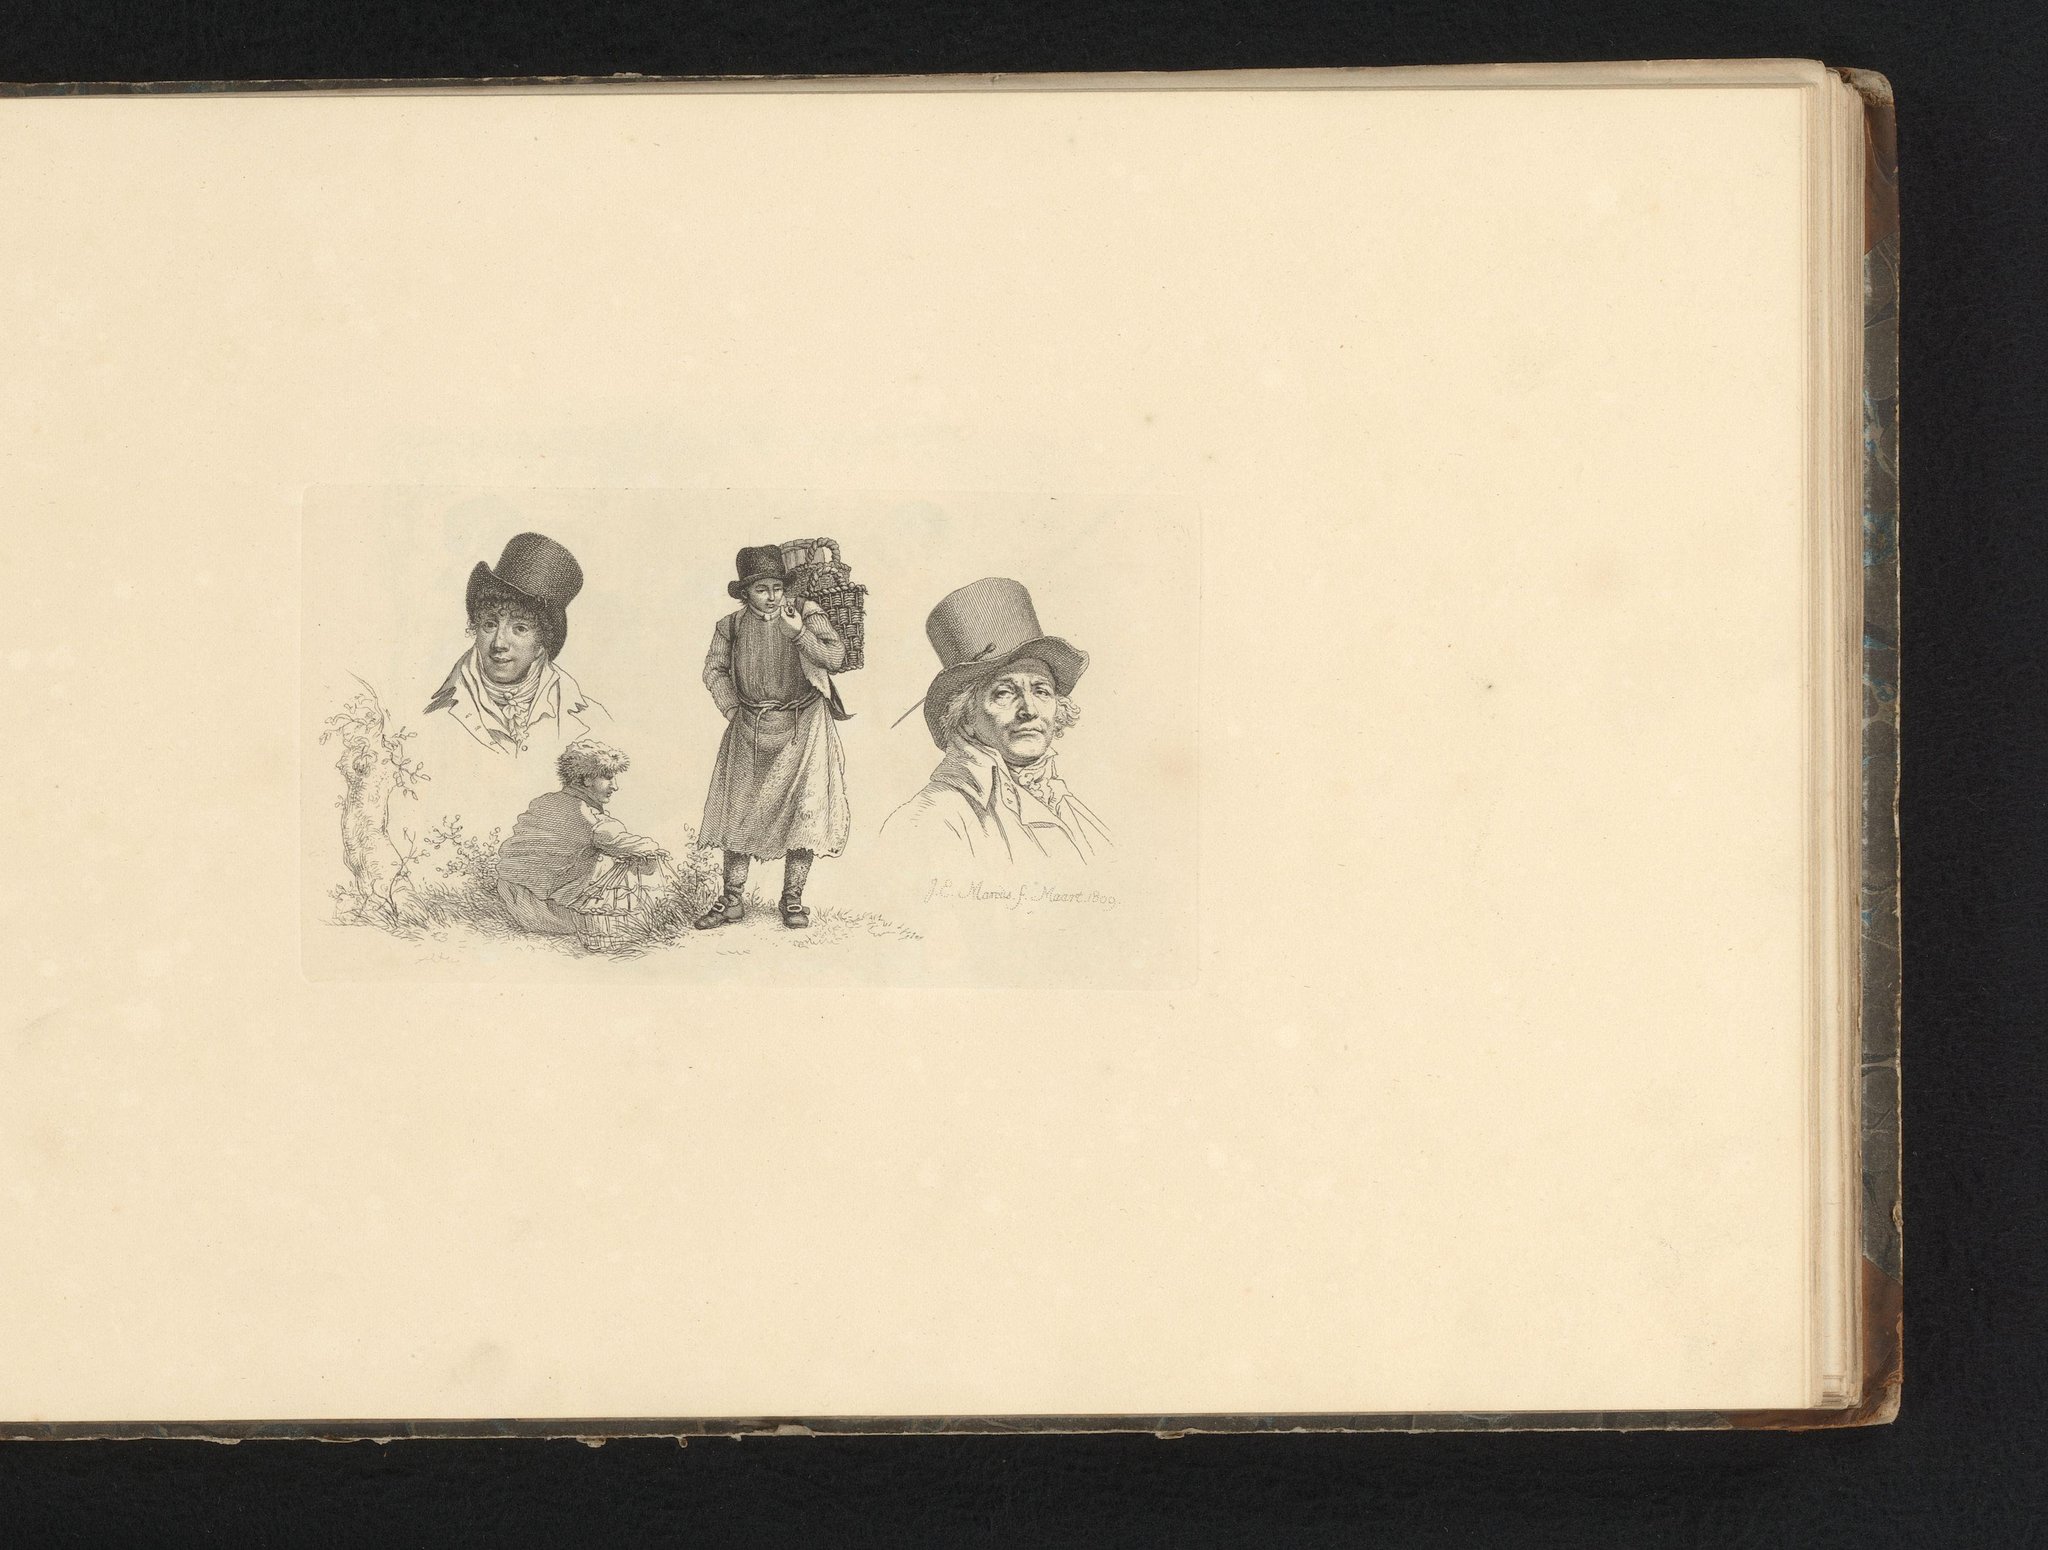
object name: print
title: Studieblad met twee mannen met manden en twee portretten van mannen in hoge hoeden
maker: jacob ernst marcus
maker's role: draughtsman, print maker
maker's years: 1774-1826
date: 1803-1809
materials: paper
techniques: etching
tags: container made of plant material other than wood: basket, sitting on the ground, head-gear: top hat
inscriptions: date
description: Deze prent maakt deel uit van een album.